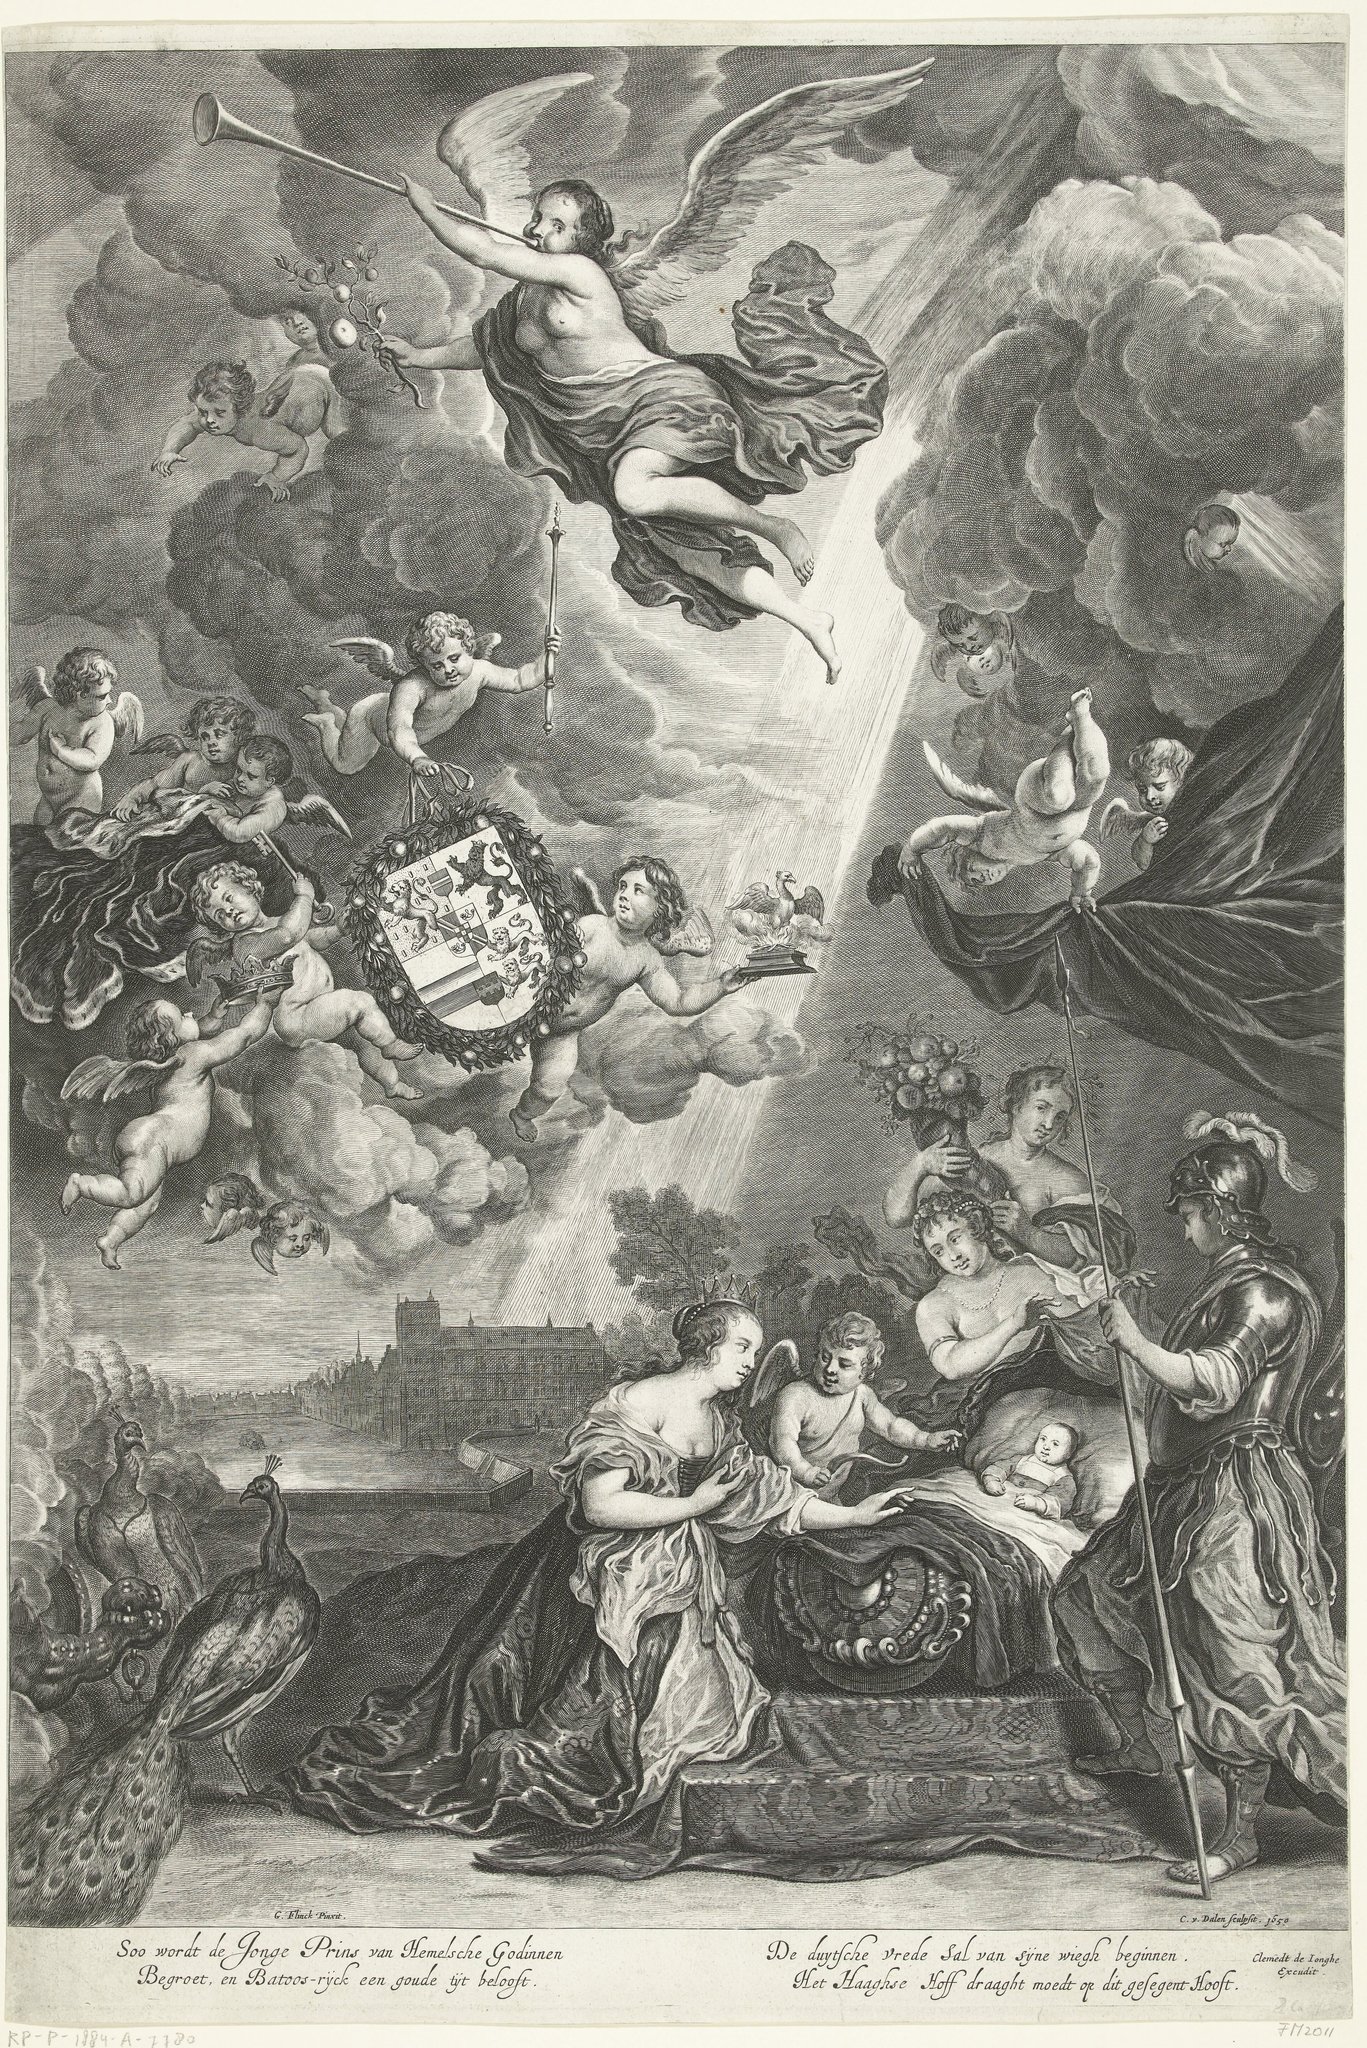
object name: print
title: Allegorie op de geboorte van prins Willem III, 1650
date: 1649-1650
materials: paper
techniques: engraving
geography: northern netherlands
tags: the hague, william iii (prince of orange and king of england, scotland, and ireland), fame; 'fama', 'fama buona', 'fama chiara' (ripa)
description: Allegorie op de geboorte van prins Willem III, 14 november 1650. Om de wieg met het kind staan en knielen Minerva, Juno en Cupido en Flora. Links de pauwen van Juno. In het verschiet de Hofvijver en de gebouwen van het Binnenhof. In de lucht dragen engelen het wapen van Nassau en verkondigt de Faam met oranjetak en bazuin het nieuws van de geboorte van de prins. Onderaan een vers van vier regels.